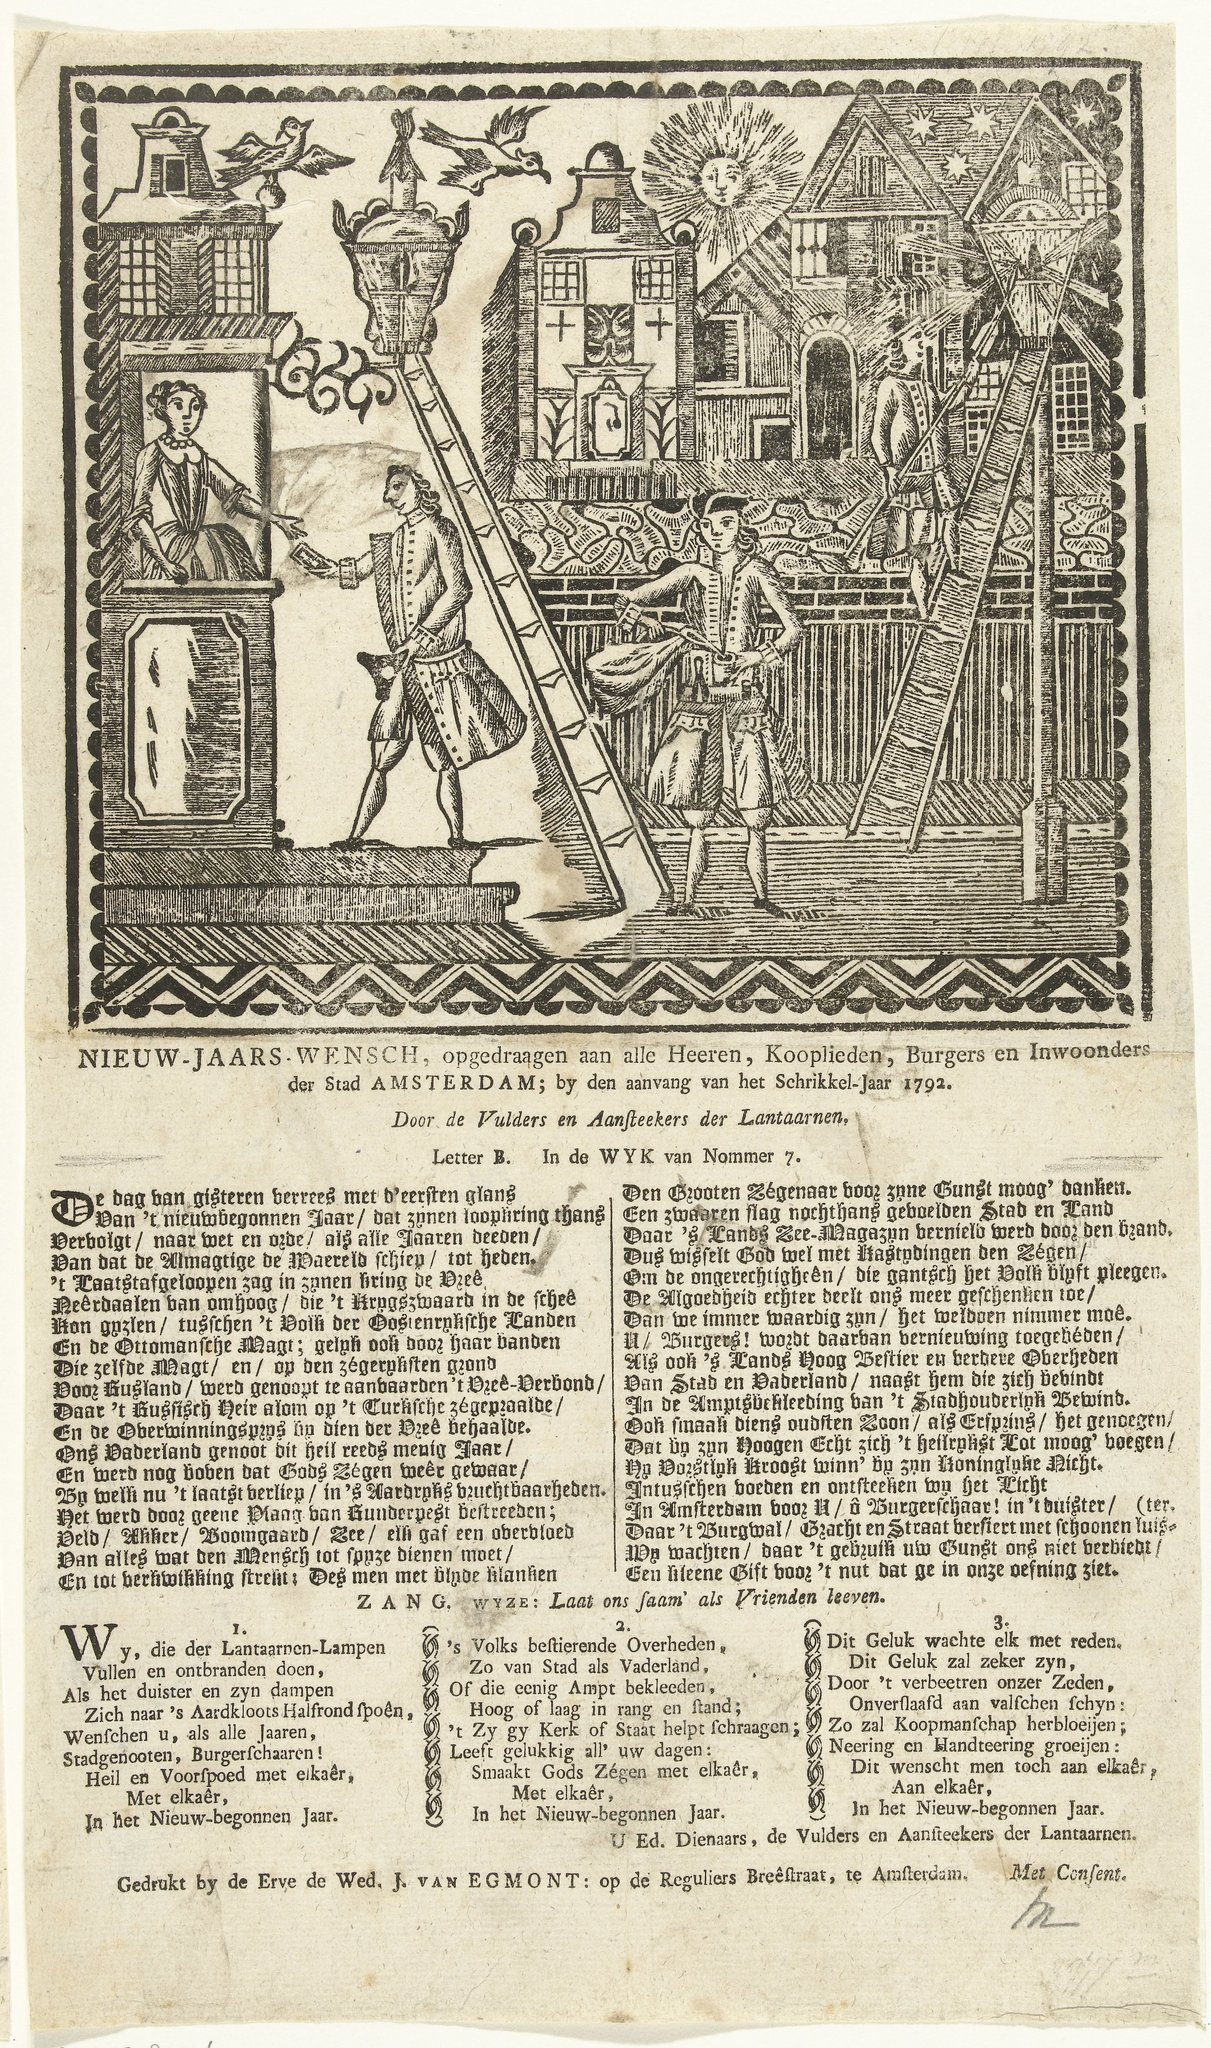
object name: print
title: Nieuw-Jaars-Wensch, opgedraagen aan alle Heeren, Kooplieden, Burgers en Inwoonders der Stad Amsterdam; by den aanvang van het Schrikkel-Jaar 1792. Door de Vulders en Aansteekers der Lantaarnen. Letter B. In de Wyk van Nommer 7.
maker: Anonymous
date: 1791-1792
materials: paper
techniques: letterpress printing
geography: amsterdam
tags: lantern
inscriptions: collector's mark: Lugt 2228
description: Nieuwjaarsprent voor het jaar 1792 van de Amsterdamse lantaarnopstekers in wijk nr. 7, opgedragen aan de burgers van Amsterdam. Lantaarnopstekers aan het werk op straat overdag en 's avonds. Op het blad onder de voorstelling een vers in twee kolommen met in de toezang een lied in drie kolommen.